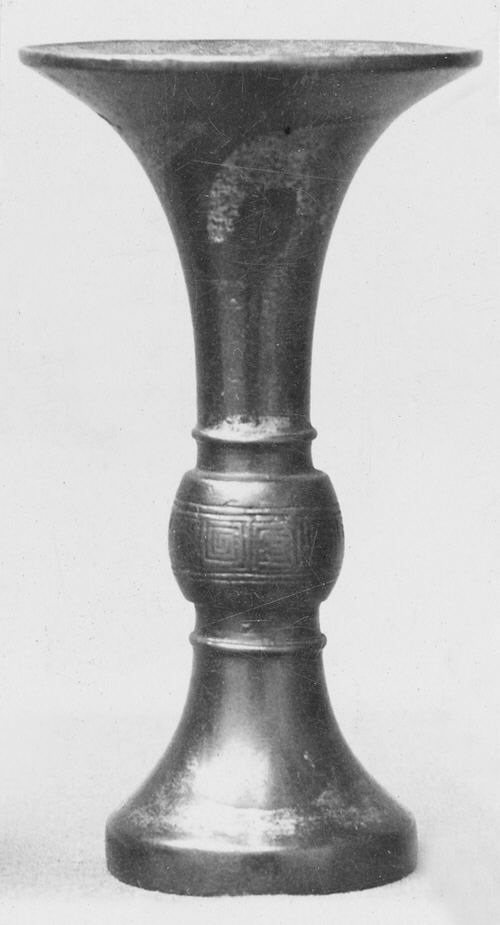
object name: vase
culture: japanese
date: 1701-1800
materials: bronze